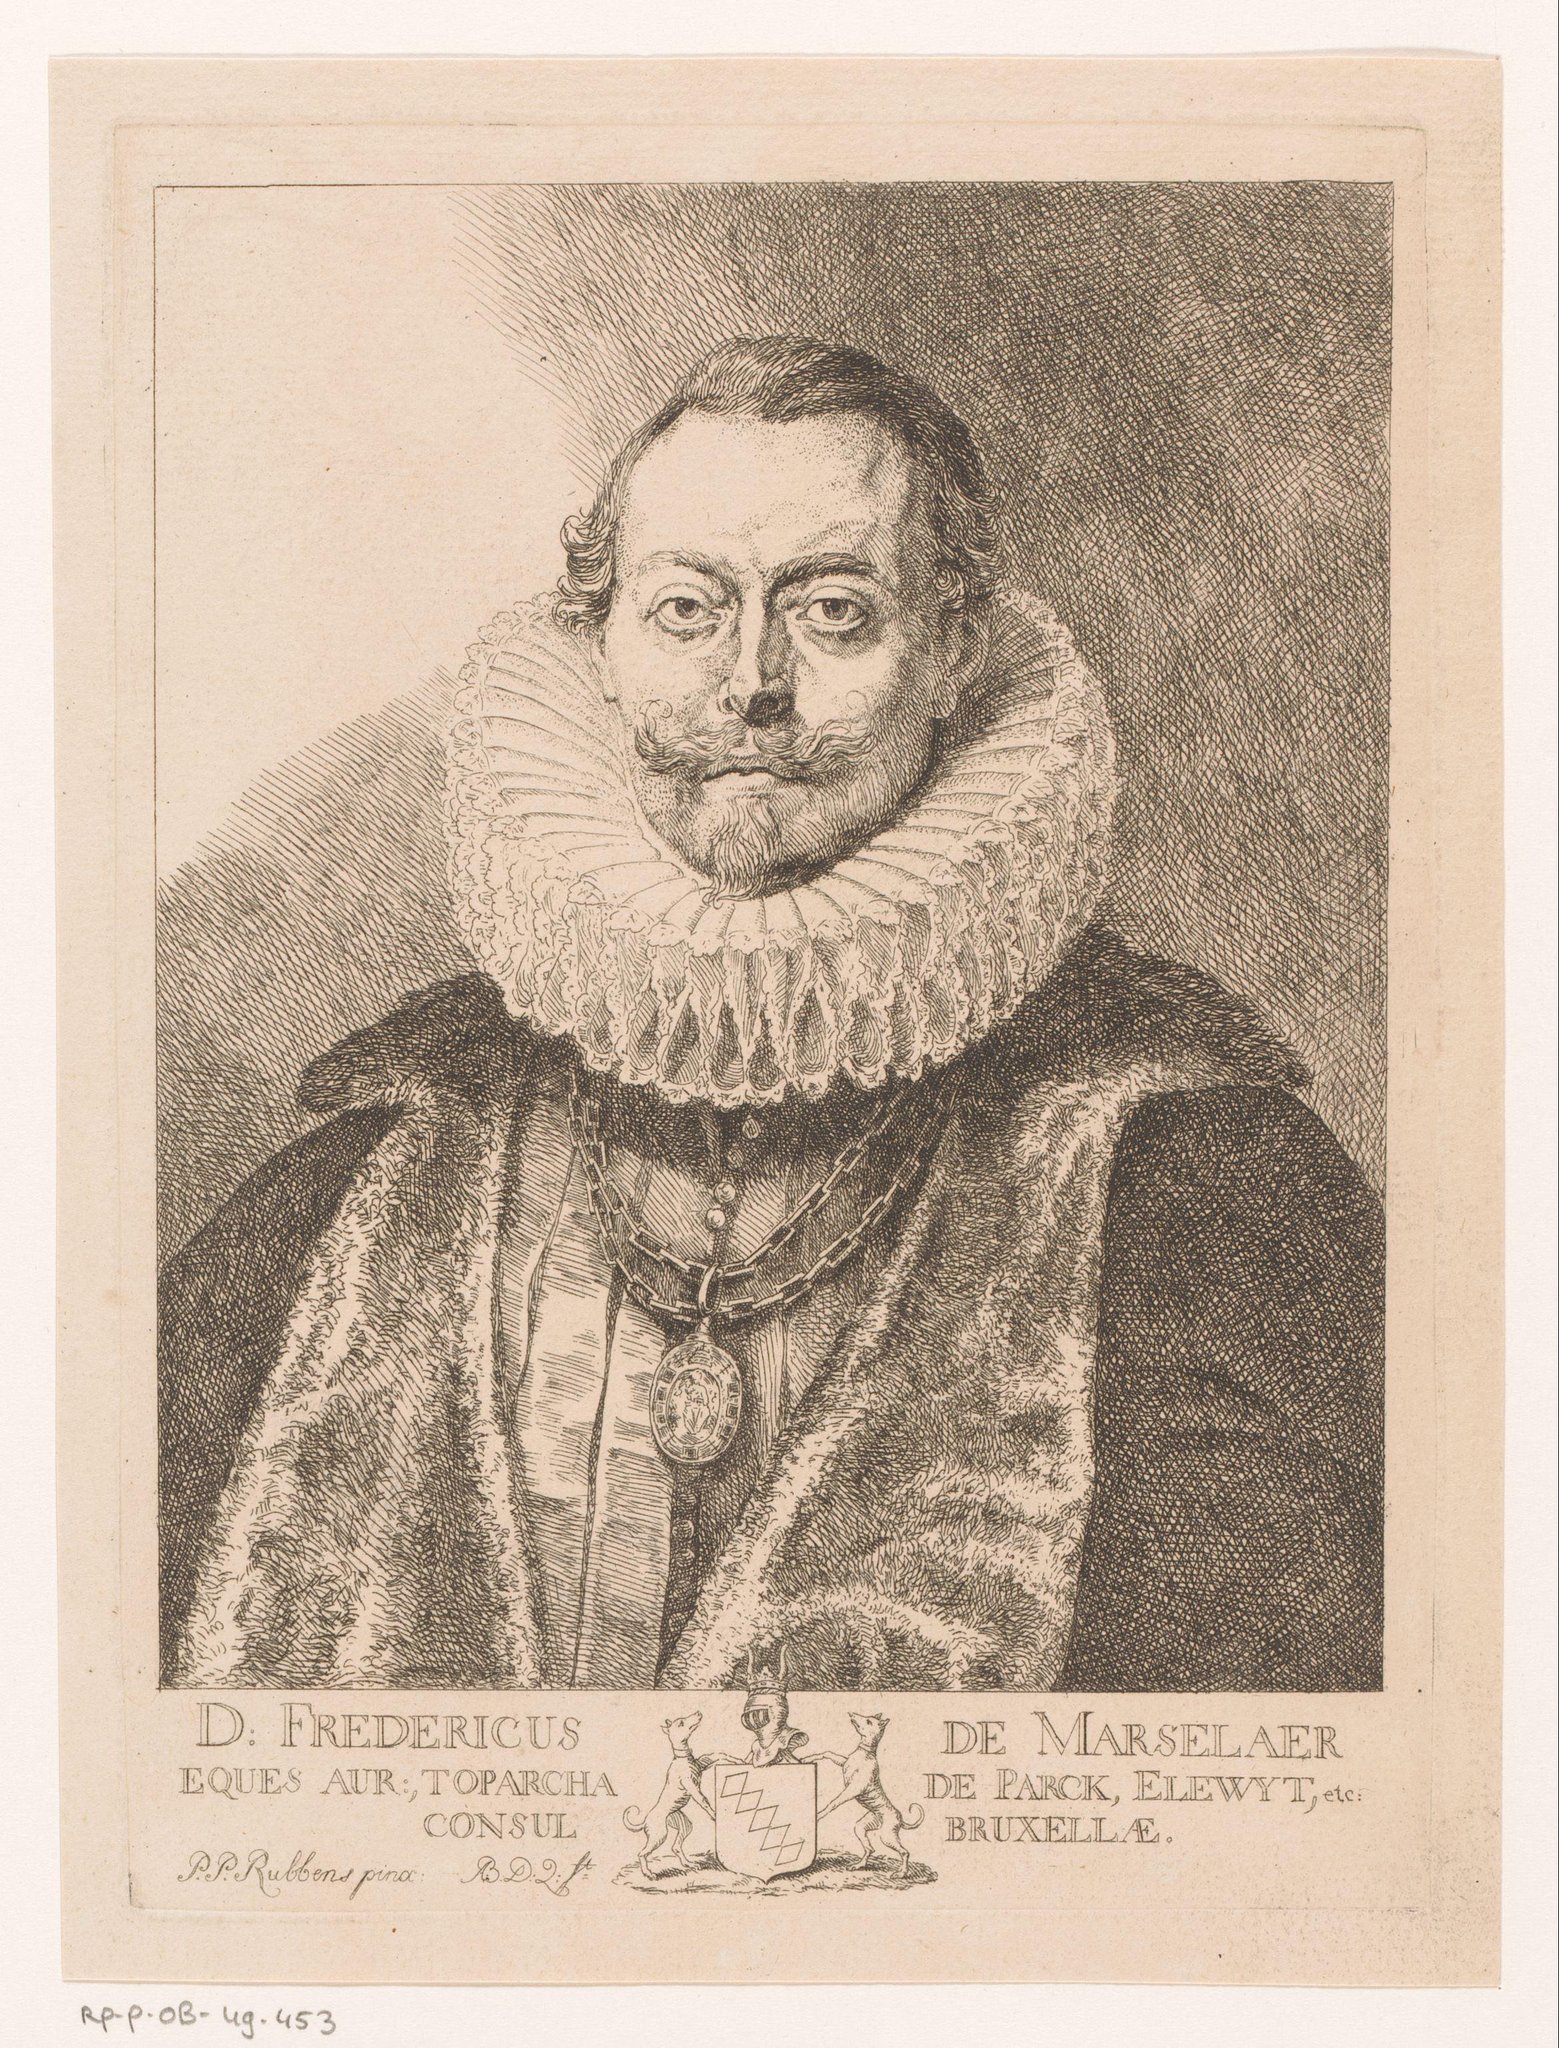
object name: print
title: D. Fredericus De Marselaer, eques aur. toparche de Parck, Elewyt, etc. consul Bruxellae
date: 1777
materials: paper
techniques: etching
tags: moustache, adult man, historical persons, armorial bearing, heraldry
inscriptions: collector's mark: Lugt 2228